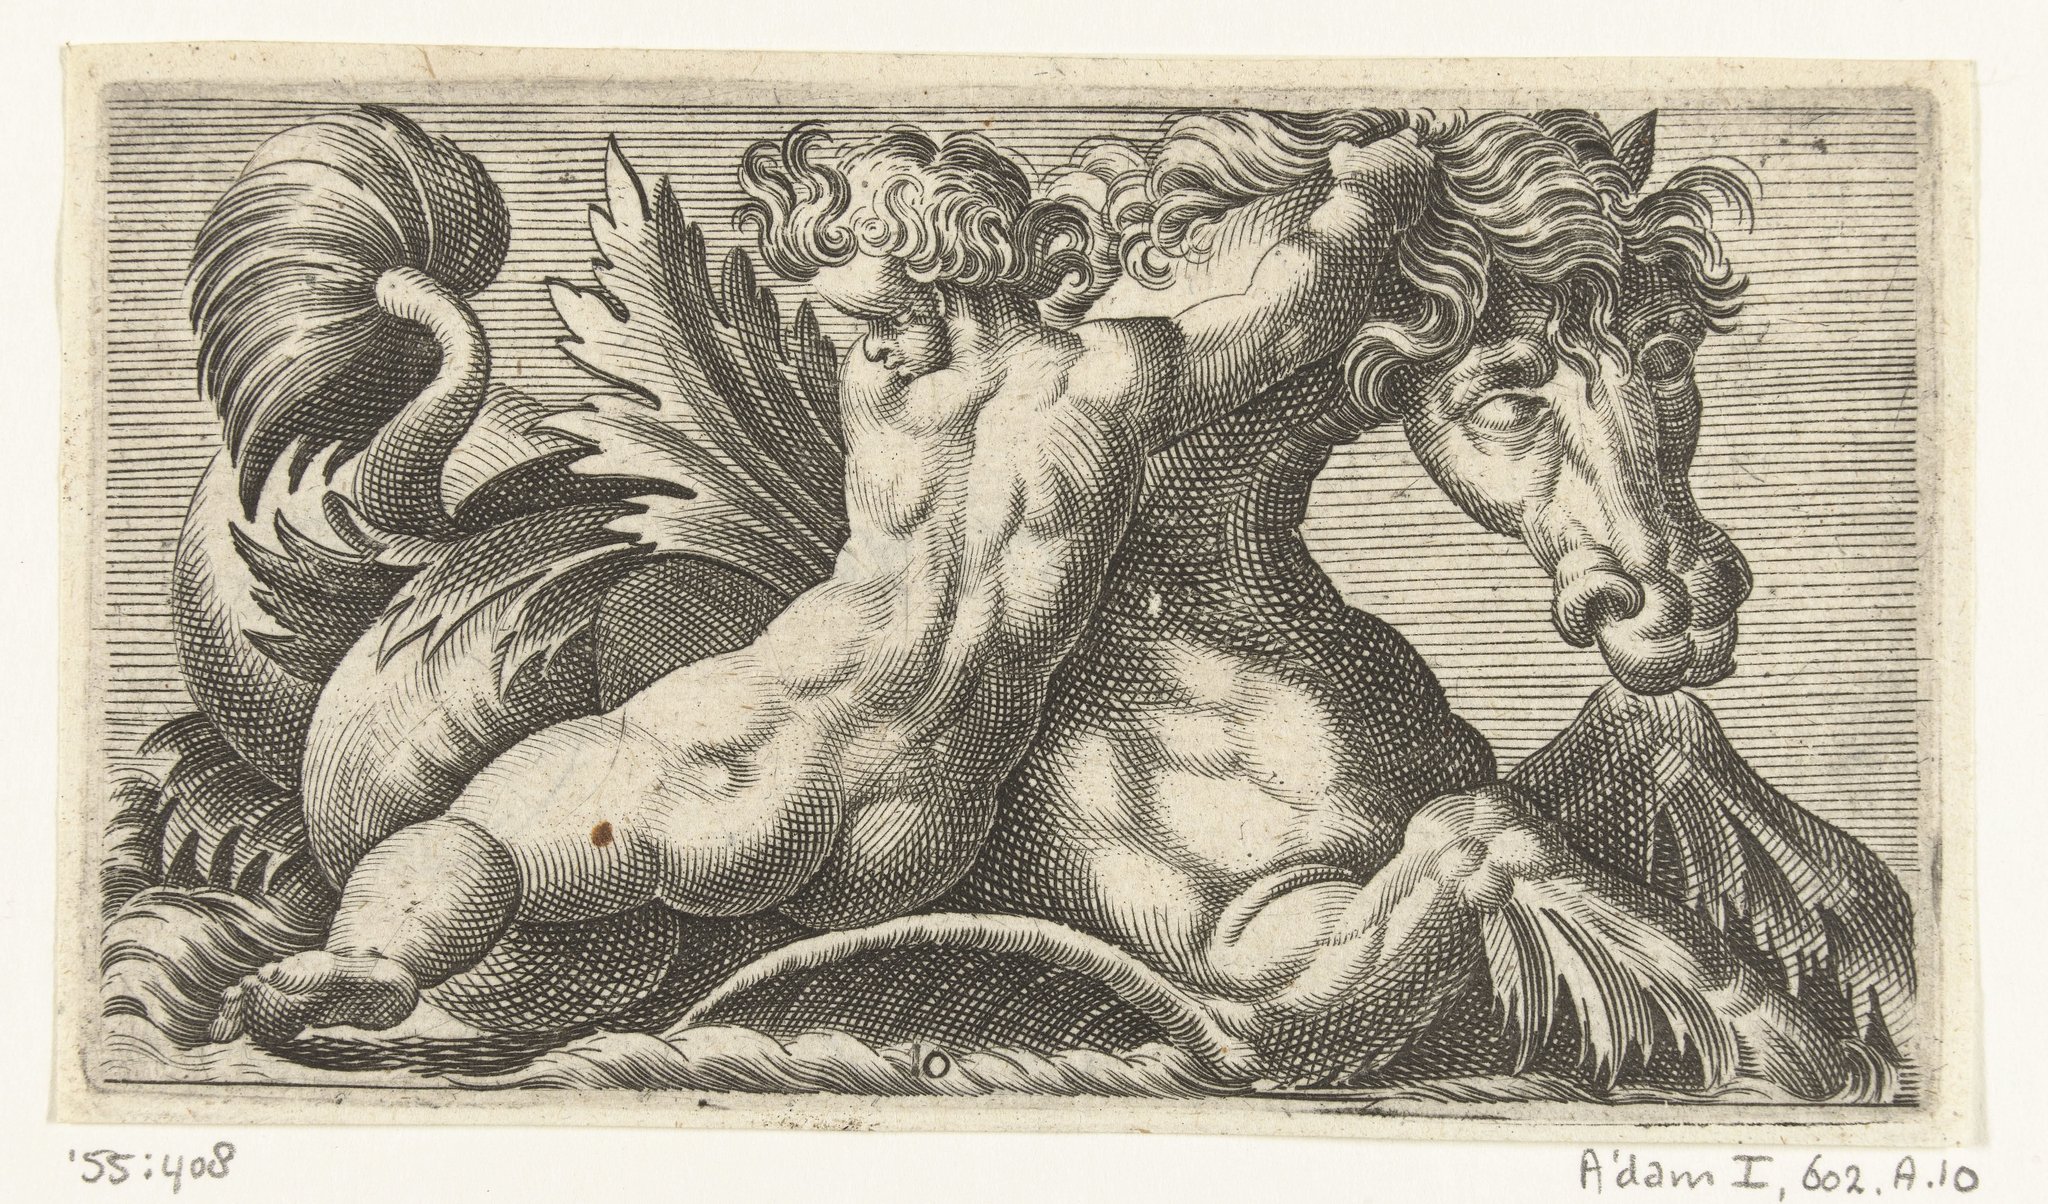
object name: ornament print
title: Putti op zeewezens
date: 1605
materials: paper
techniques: engraving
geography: germany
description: Tegenzijdige kopie naar een prent van Giovanni Andrea Maglioli.